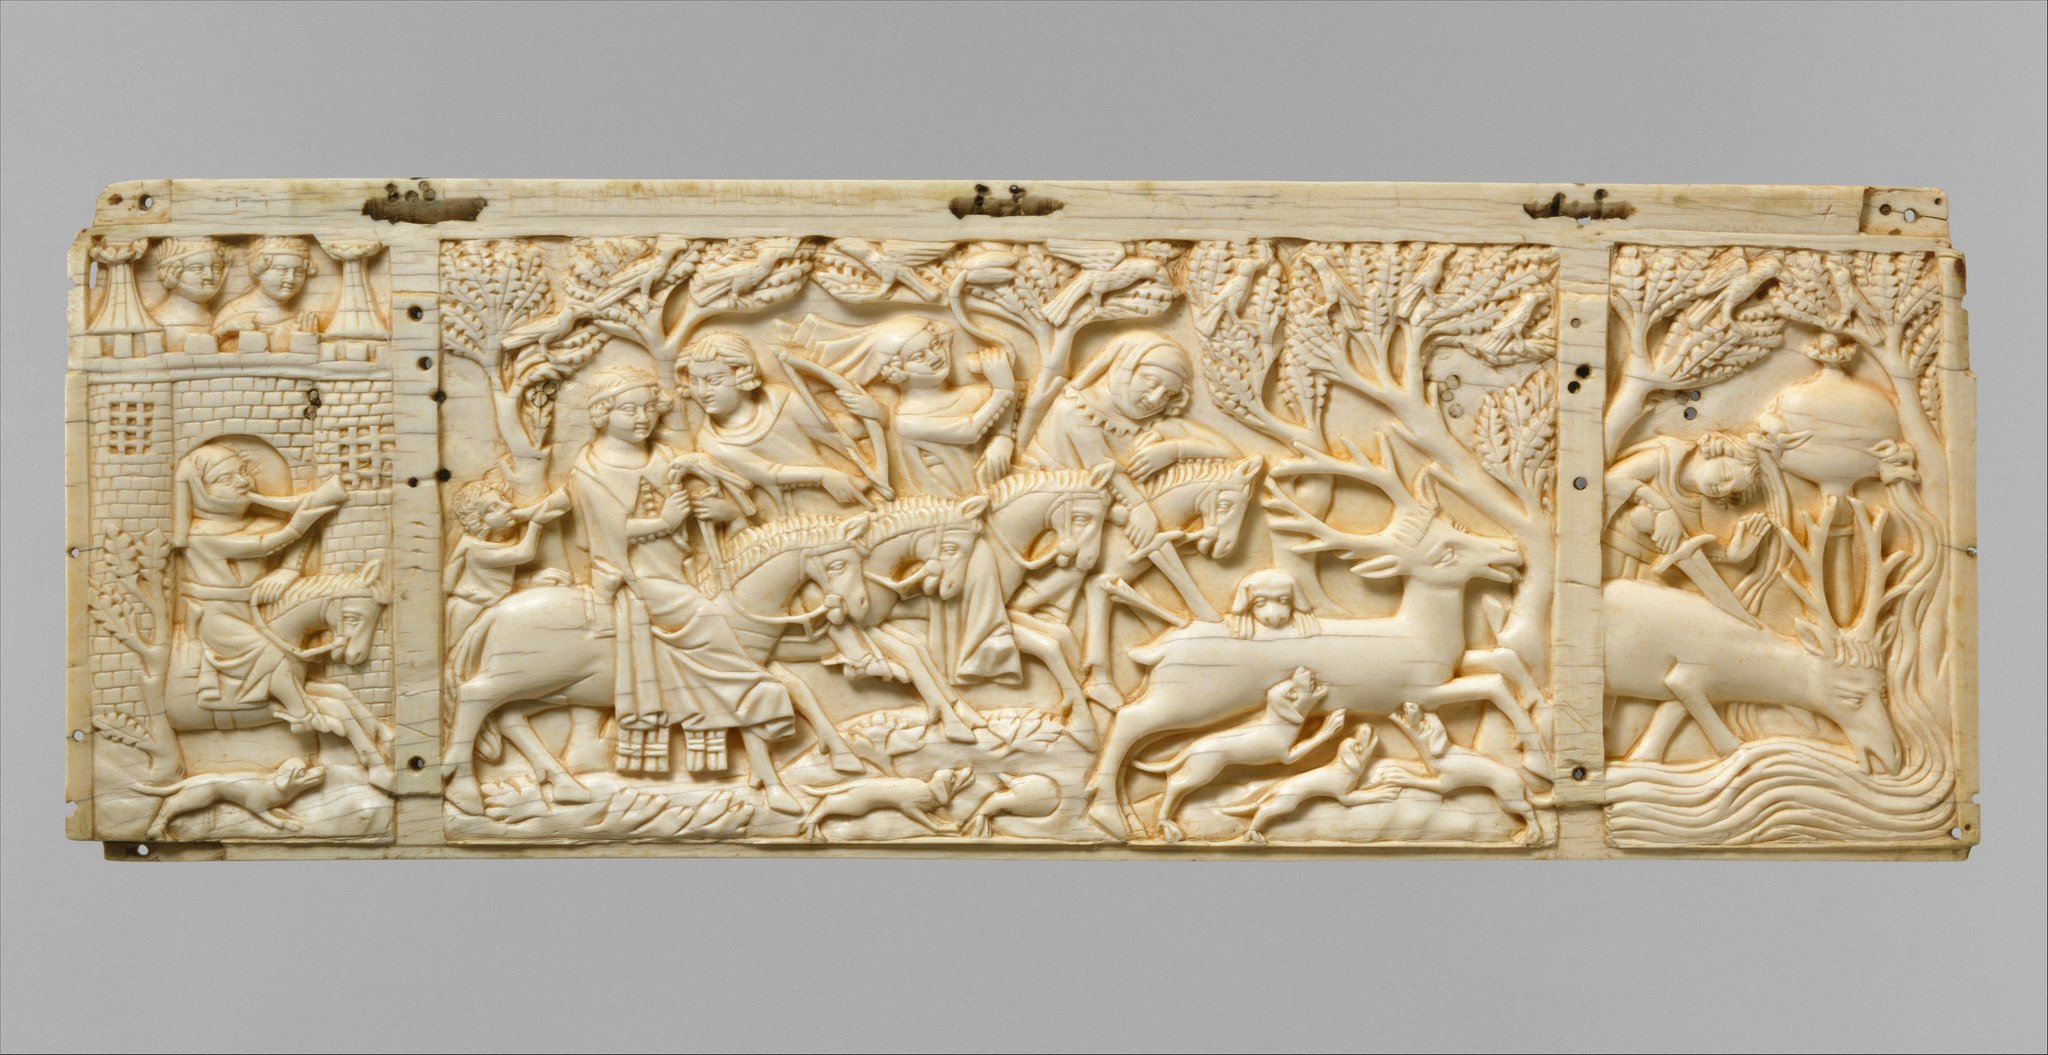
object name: casket plaque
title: Panel with Hunting Scenes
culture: french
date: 1350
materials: ivory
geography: france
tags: castles,women,hunting,deer,horses